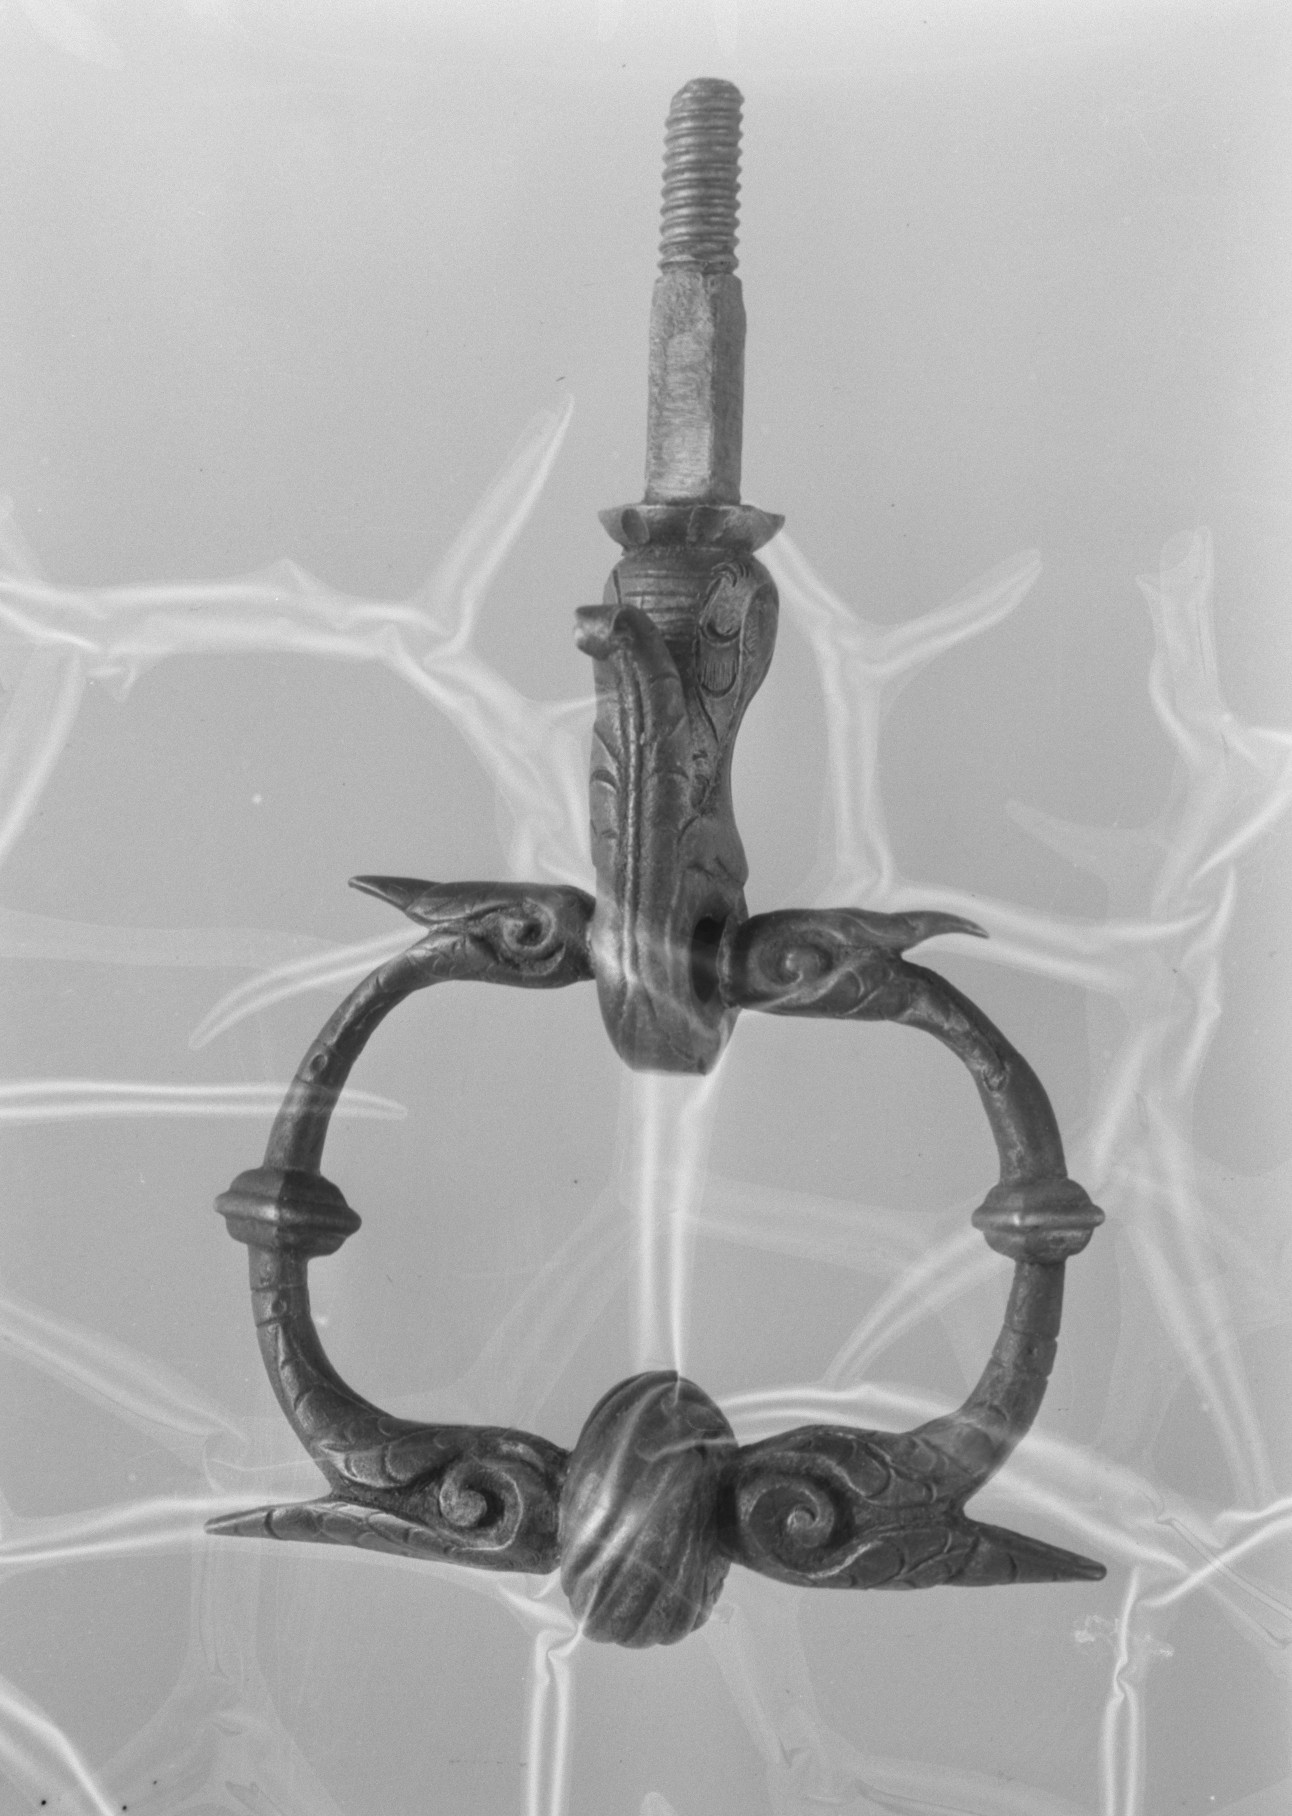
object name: door handle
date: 1560-1600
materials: iron